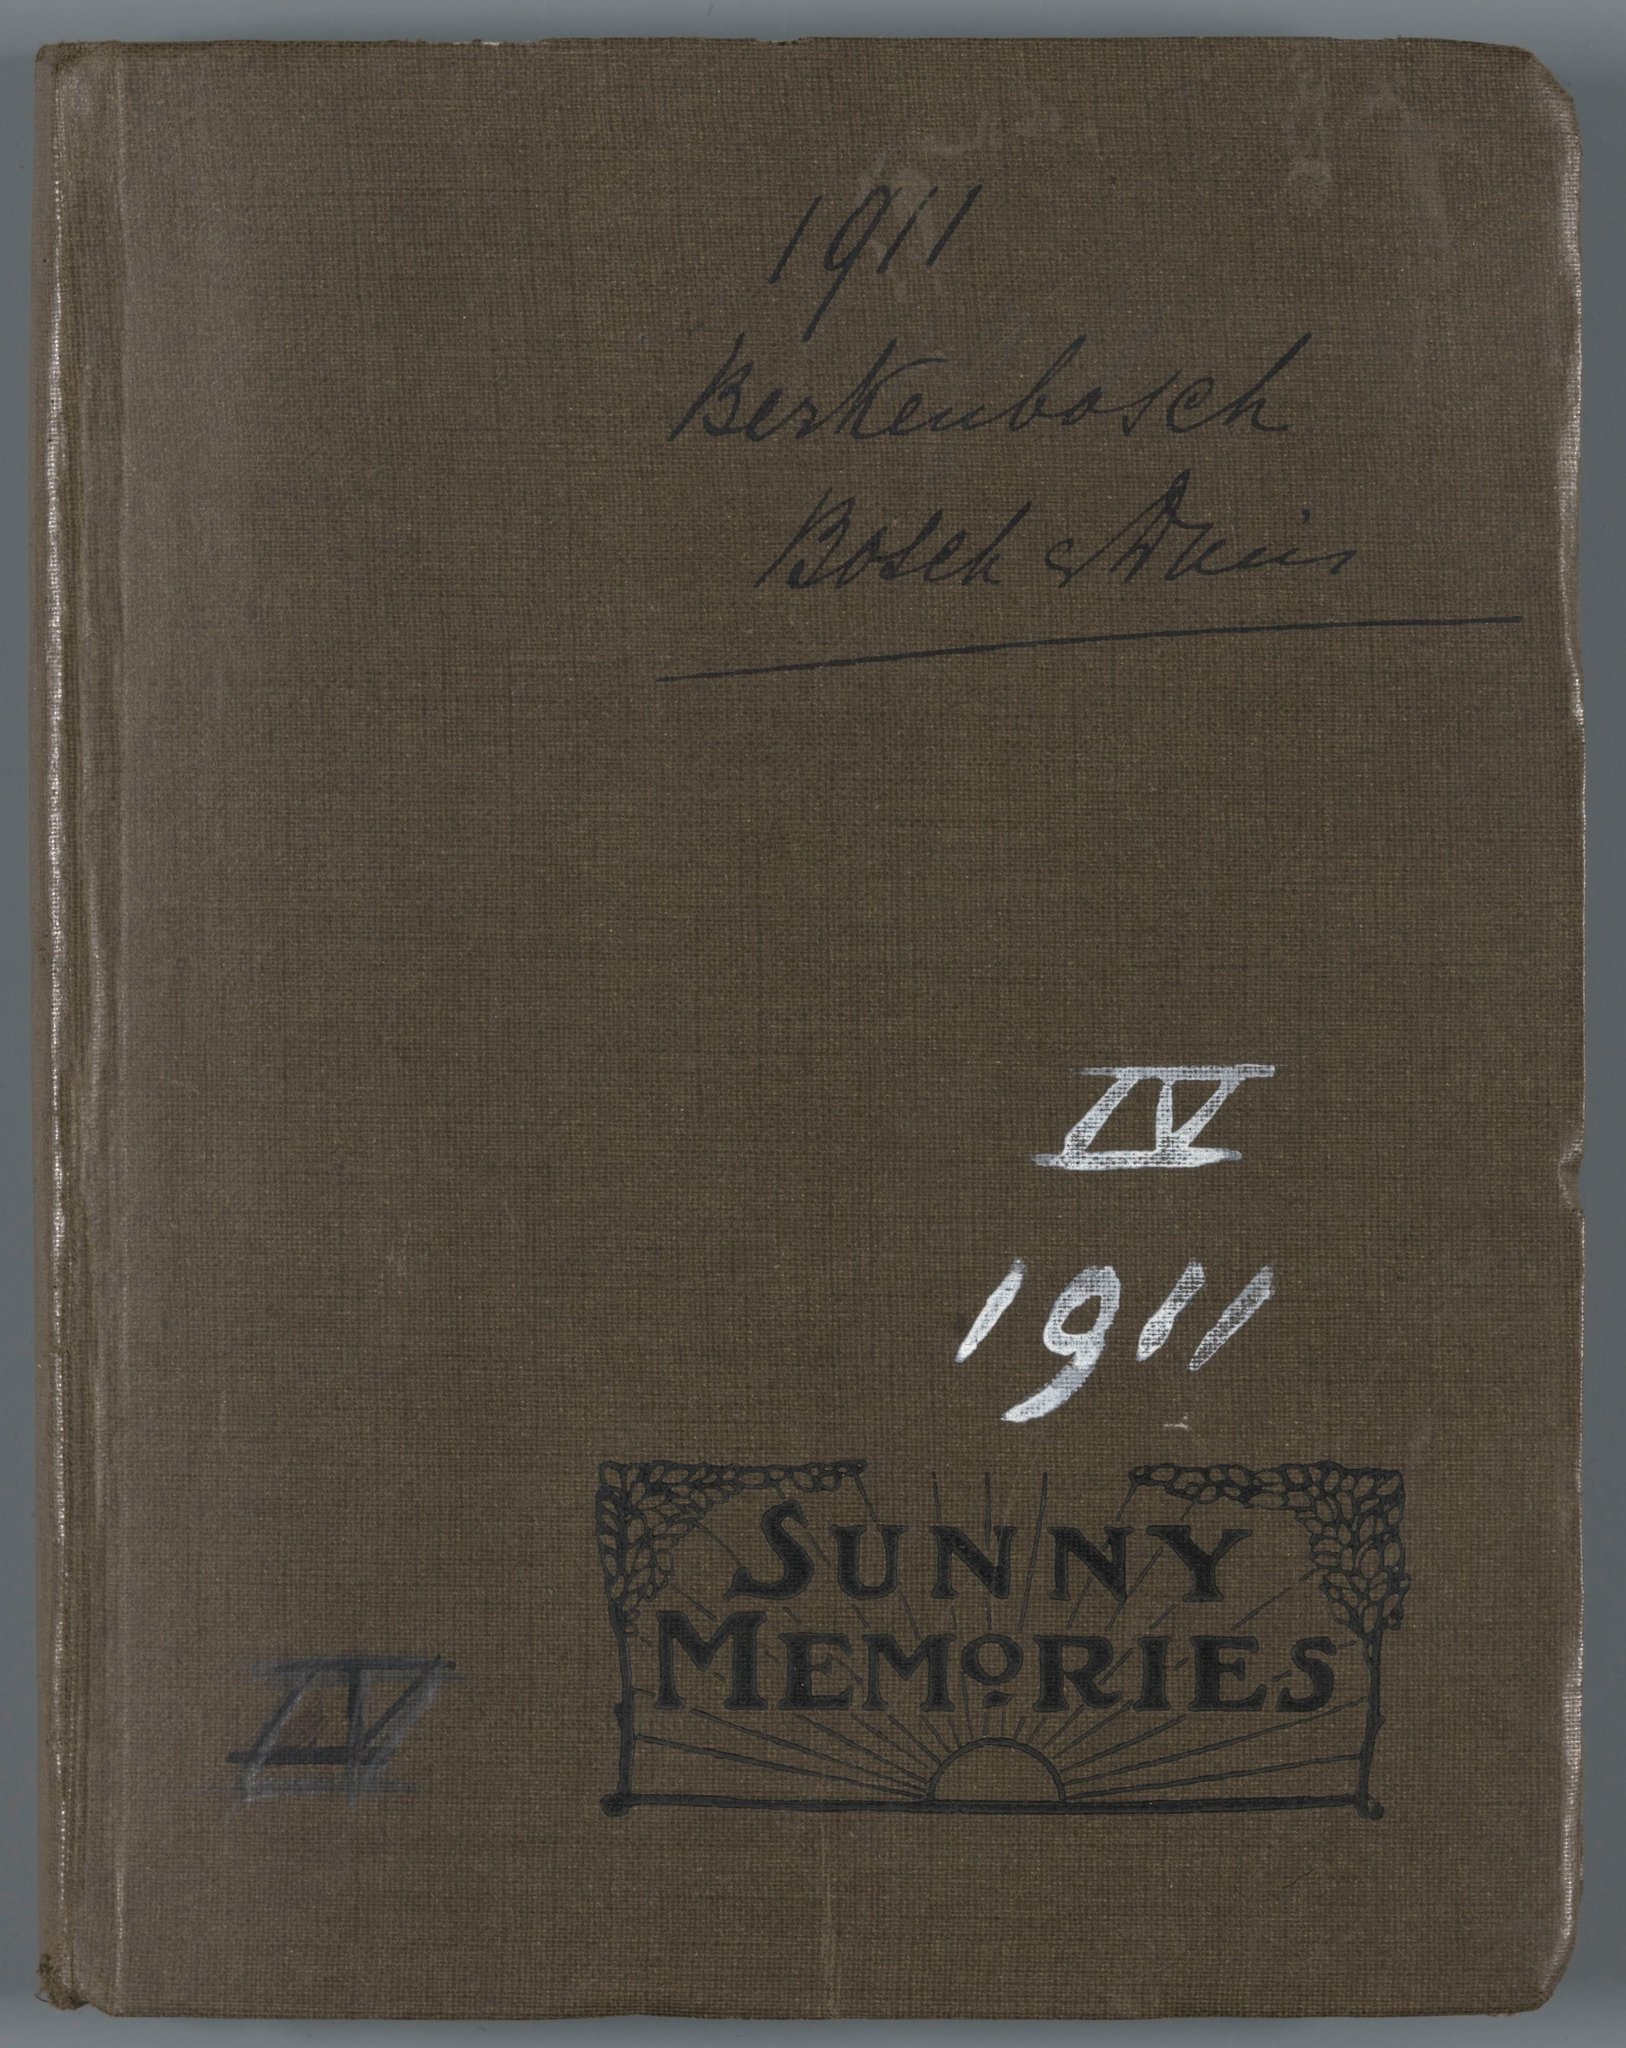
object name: slip in album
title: Fotoalbum van familie Van den Berg, 1911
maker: hendrik herman van den berg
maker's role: amateurfotograaf, jurist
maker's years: 1875-1944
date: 1911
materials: paper, cardboard, ink, textile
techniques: gelatin silver print, pen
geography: netherlands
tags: the hague, caroline louise van den berg-van den berg, carel frederik van den berg (cay), toddler, historical persons, family life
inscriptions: inscription: ‘SUNNY/ MEMORIES’, inscription: ‘1911/ Berkenbos/ Bos en Duin/ IV/ 1911/ IV’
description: Plak- en insteekalbum met 34 foto's op 24 bladen. Één van de foto's is op de binnenzijde van het voorplat geplakt. Het album is waarschijnlijk samengesteld door Hendrik Herman van den Berg. Hij is waarschijnlijk ook de fotograaf. Het album bevat foto's van zijn zoon Cay van den Berg als peuter en foto's van de familie in het bos.